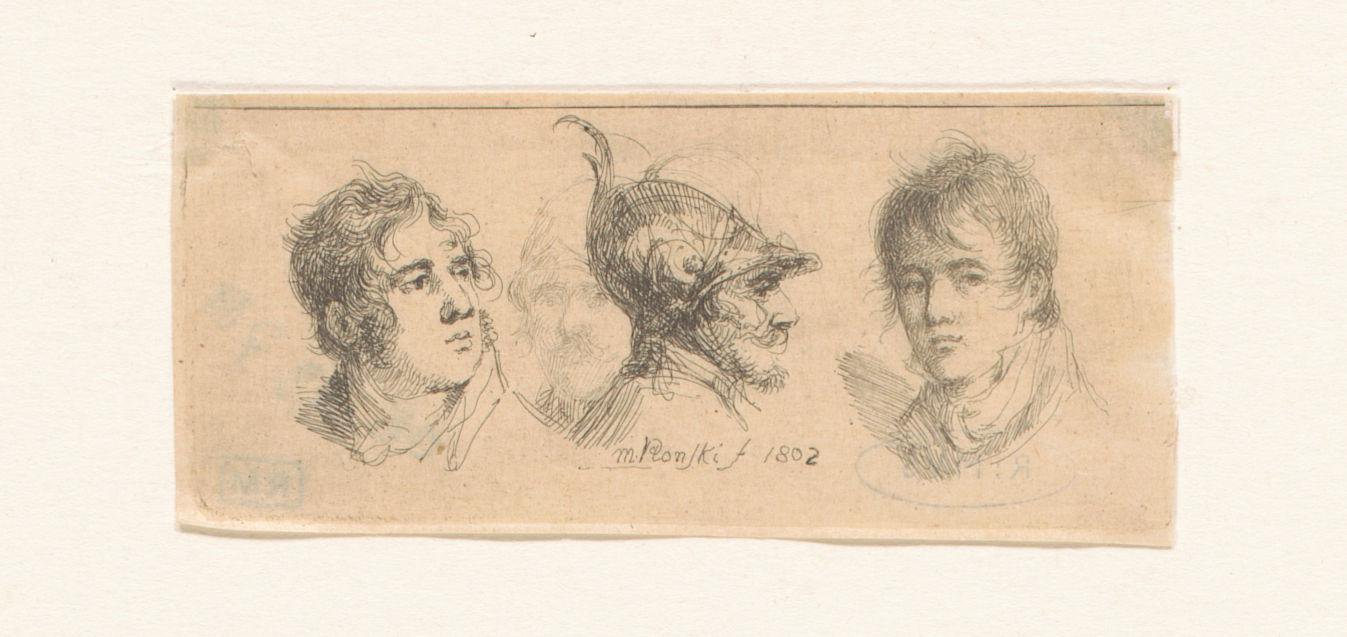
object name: print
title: Studie van drie hoofden, waarvan een met helm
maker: michał płoński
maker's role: print maker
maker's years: 1778-1812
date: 1802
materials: paper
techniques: etching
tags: helmet, adult man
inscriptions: collector's mark: Lugt 2227, collector's mark: Lugt 2228